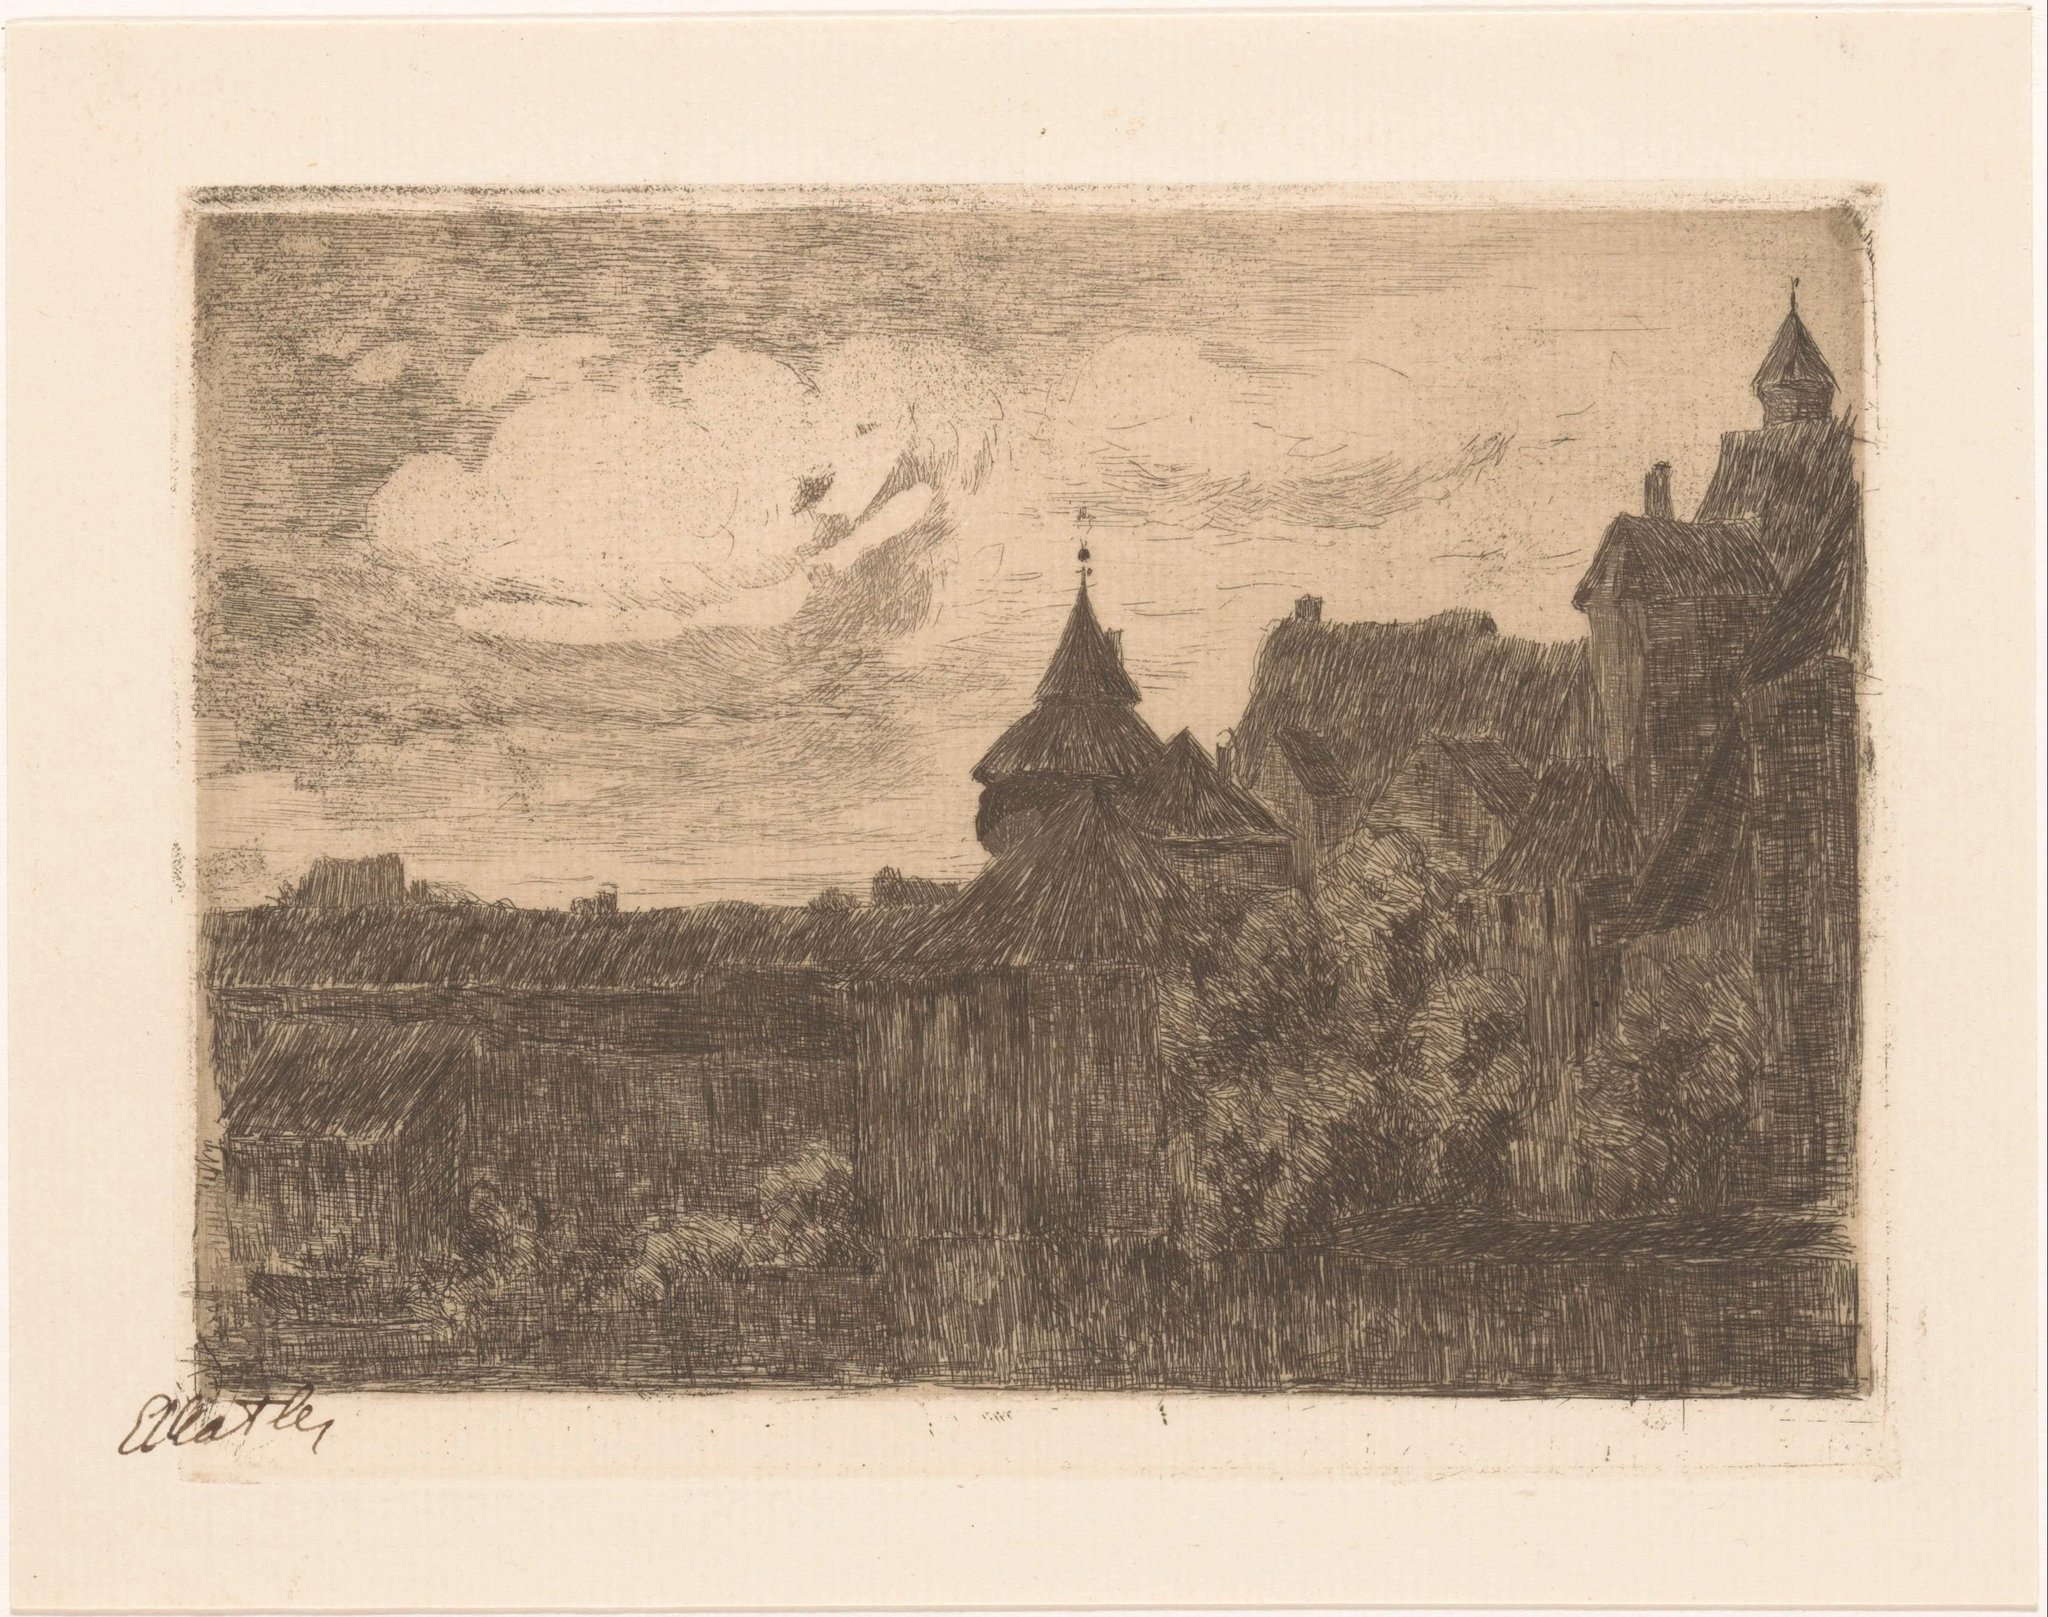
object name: print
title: Neurenberg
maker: etha fles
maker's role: print maker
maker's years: 1857-1948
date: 1867-1910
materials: paper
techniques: drypoint, intaglio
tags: castle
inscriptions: collector's mark: Lugt 2228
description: Enkele gebouwen en torens van Kasteel Neurenberg.